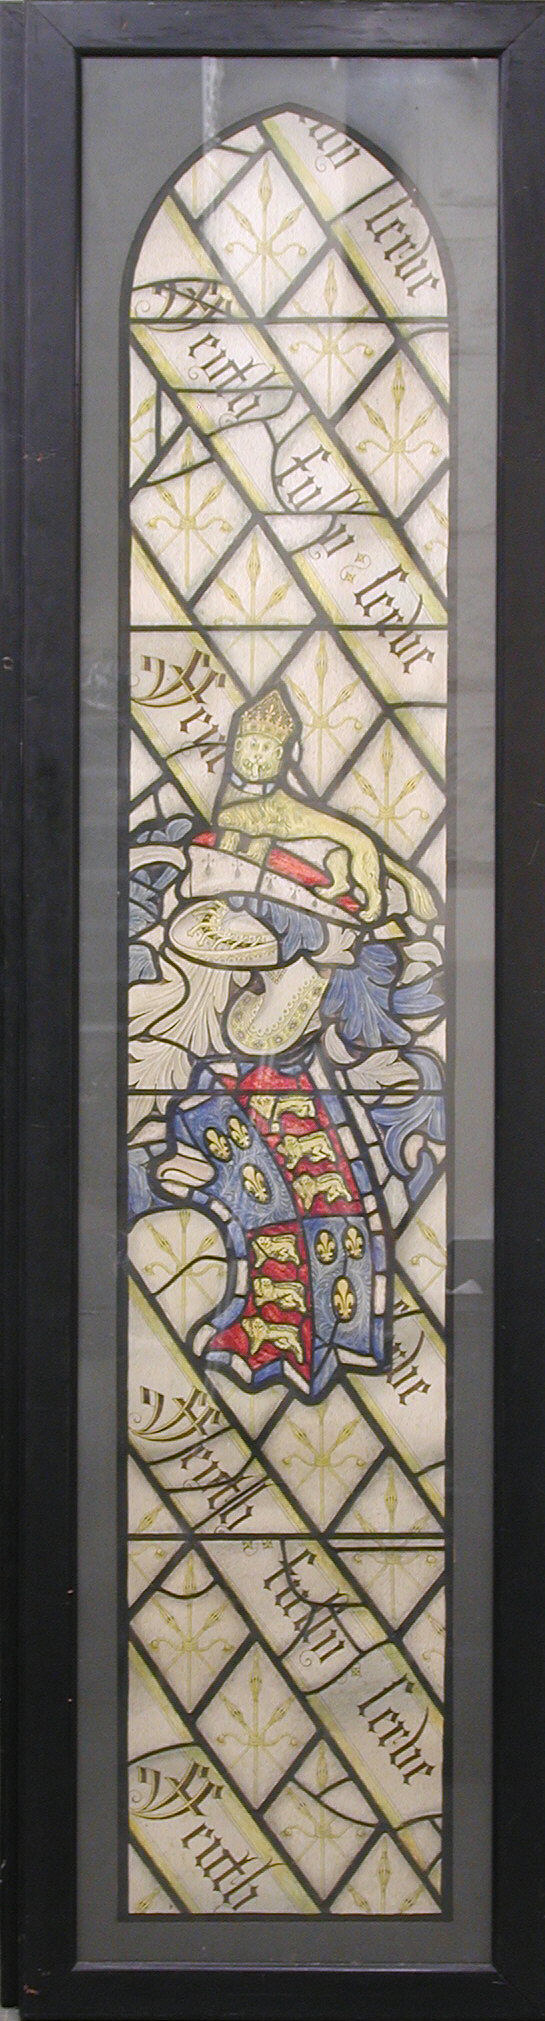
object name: panel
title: Panel with Coat of Arms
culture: british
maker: alfred a. bradbury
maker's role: artist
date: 1901-1933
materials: paper, pencil, watercolor